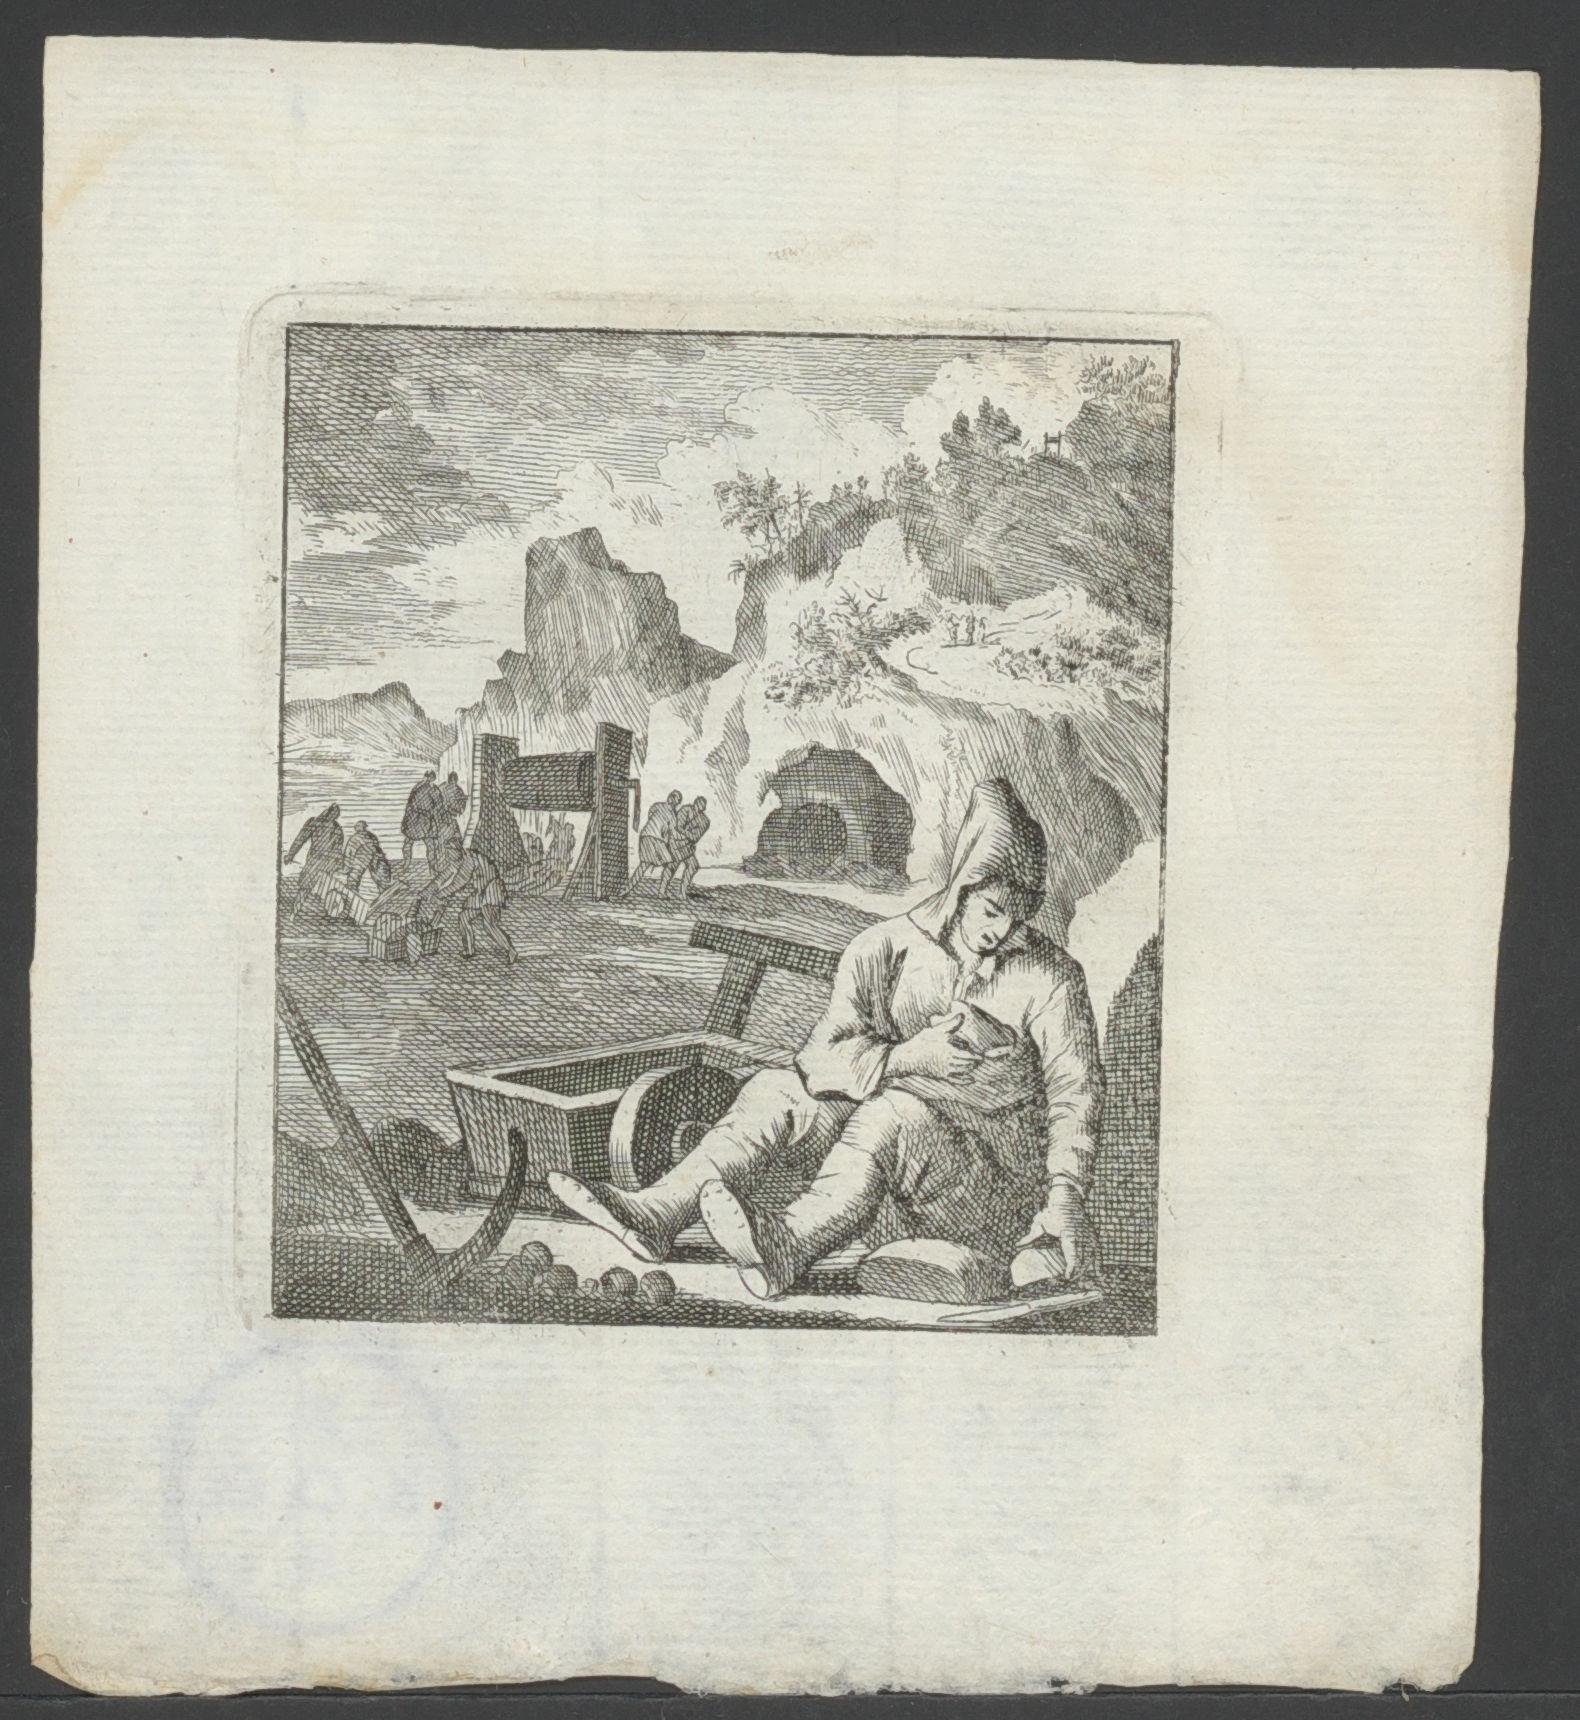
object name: print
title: Bergwerker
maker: Anonymous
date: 1694-1799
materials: paper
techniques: engraving, etching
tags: miner, handicrafts, craftsman at work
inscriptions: collector's mark: Lugt 1641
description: Onderwerpsrubrieken binnen de Atlas Zeden en Gewoonten: Handel, Nijverheid en Verkeer, Beroep en bedrijf, Complete suites.